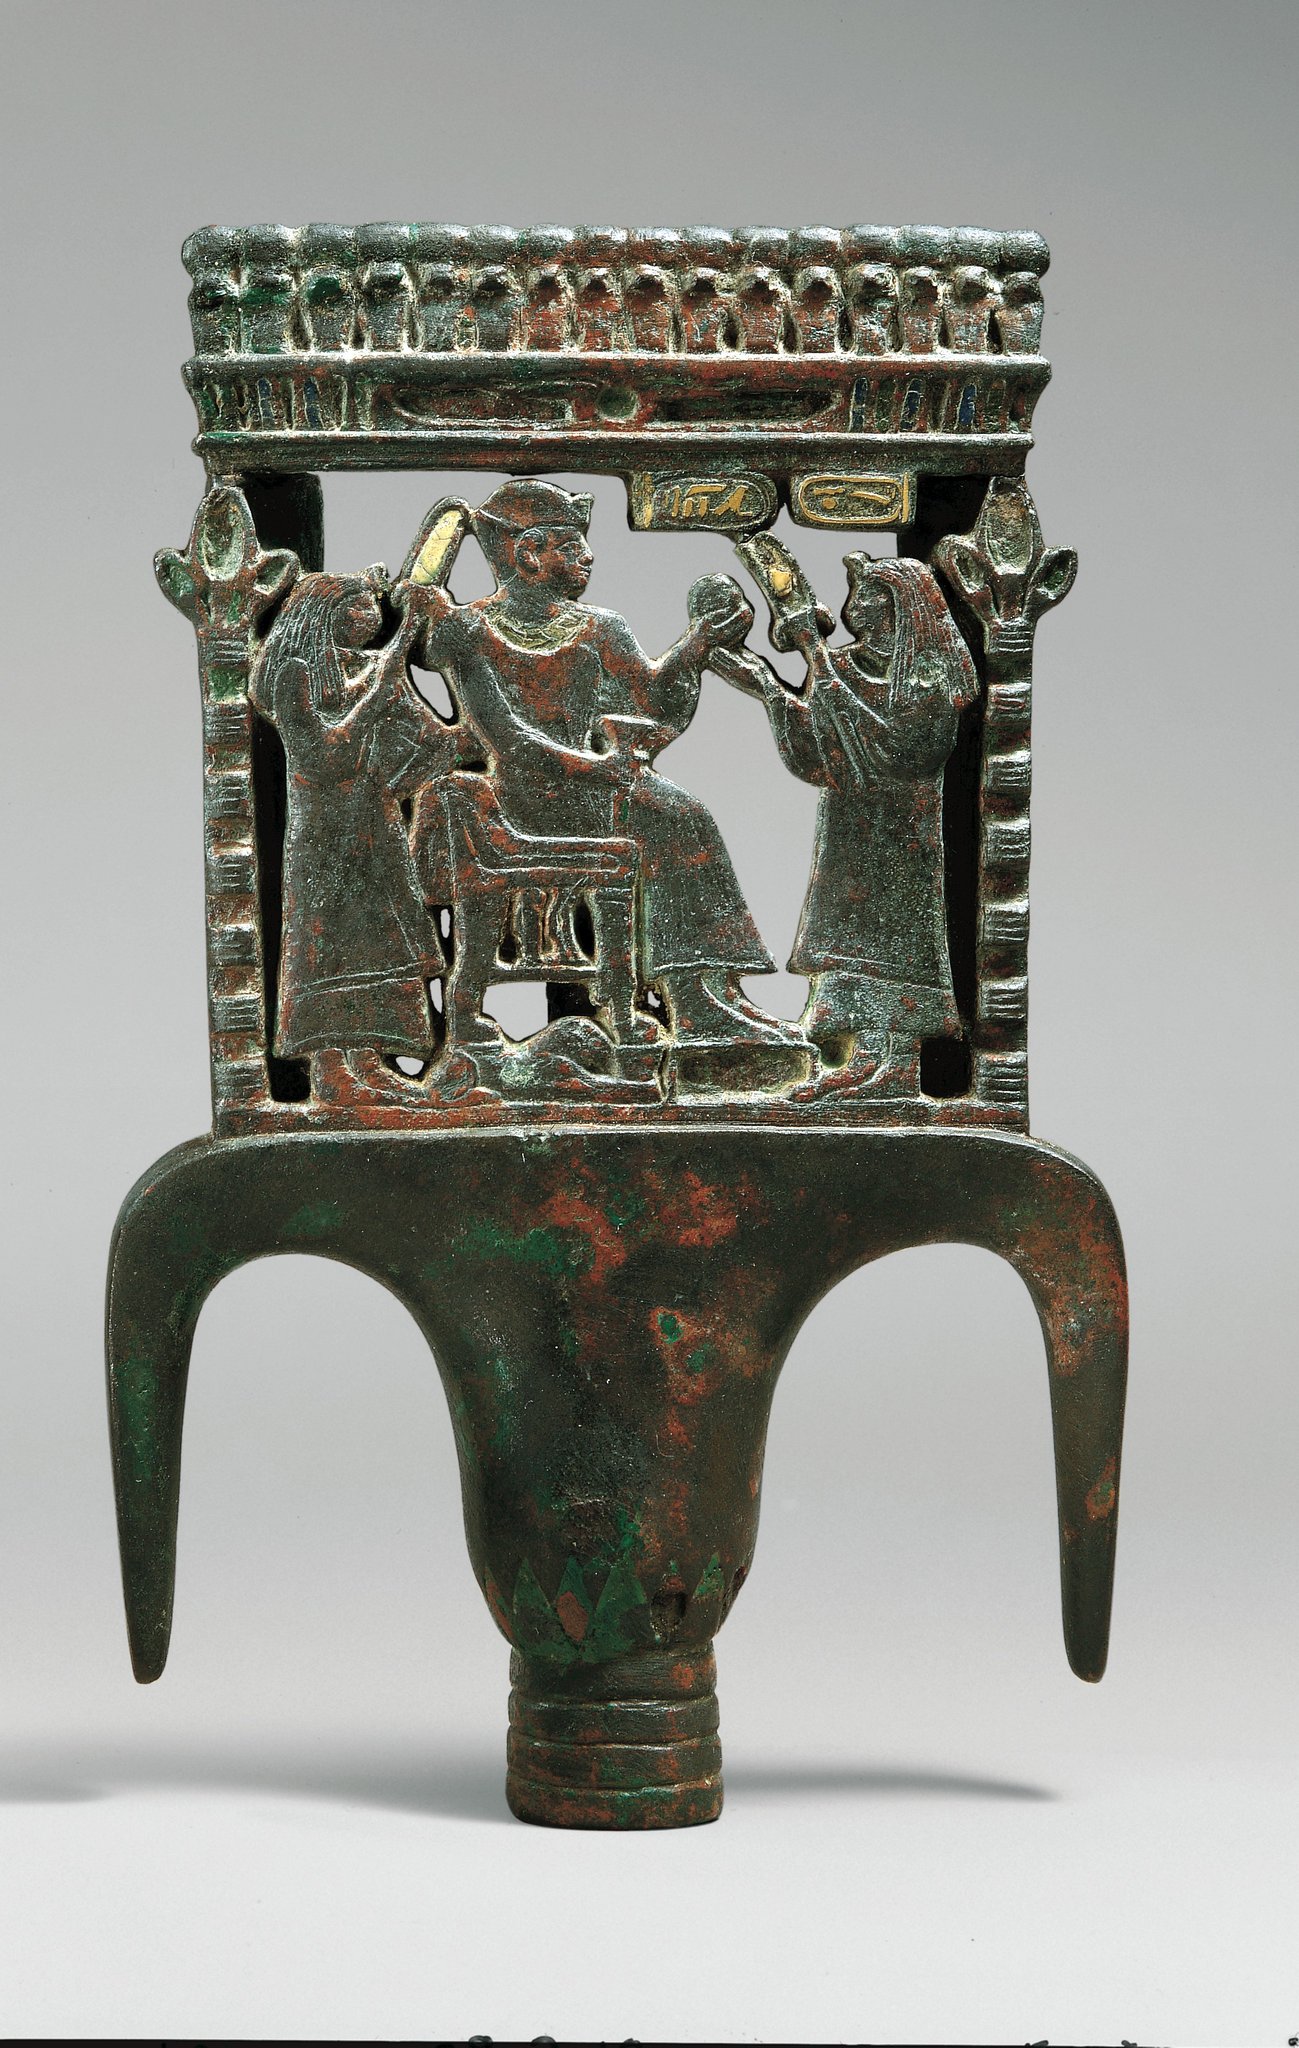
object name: fan palm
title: Palm of a Ceremonial Fan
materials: bronze, glass, gold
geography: egypt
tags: kings,goddess